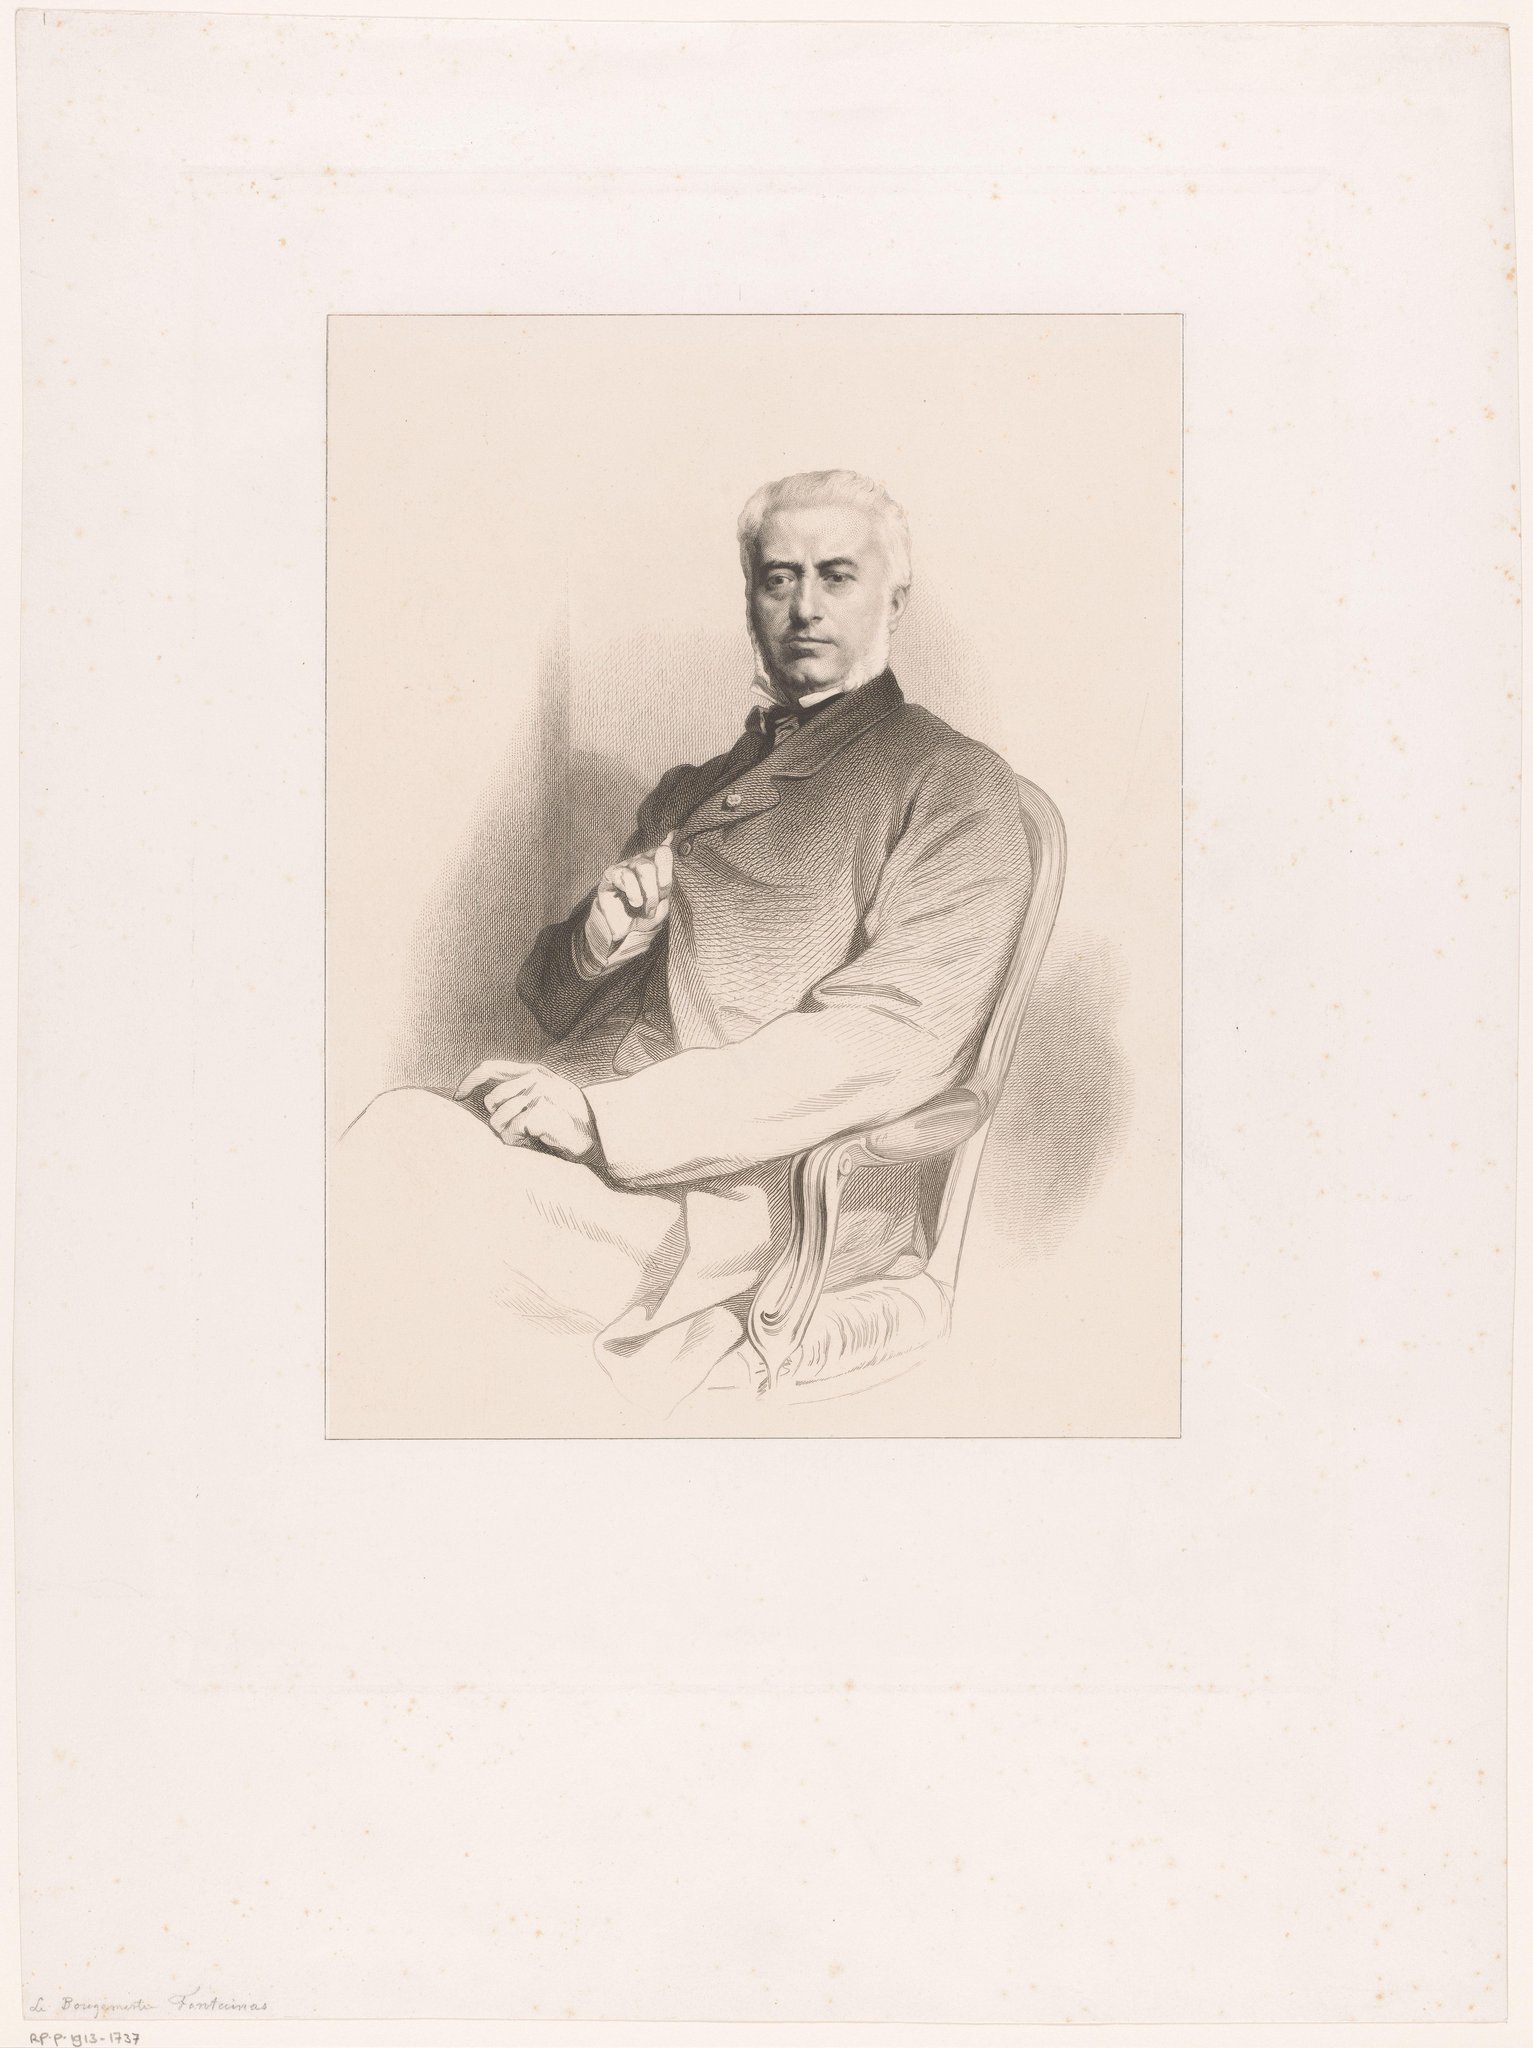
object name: print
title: Portret van André-Napoléon Fontainas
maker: jean-baptiste meunier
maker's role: print maker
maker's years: 1821-1900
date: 1831-1900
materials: paper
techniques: engraving, etching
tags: brussels, adult man, historical persons, chair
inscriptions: collector's mark: Lugt 2228